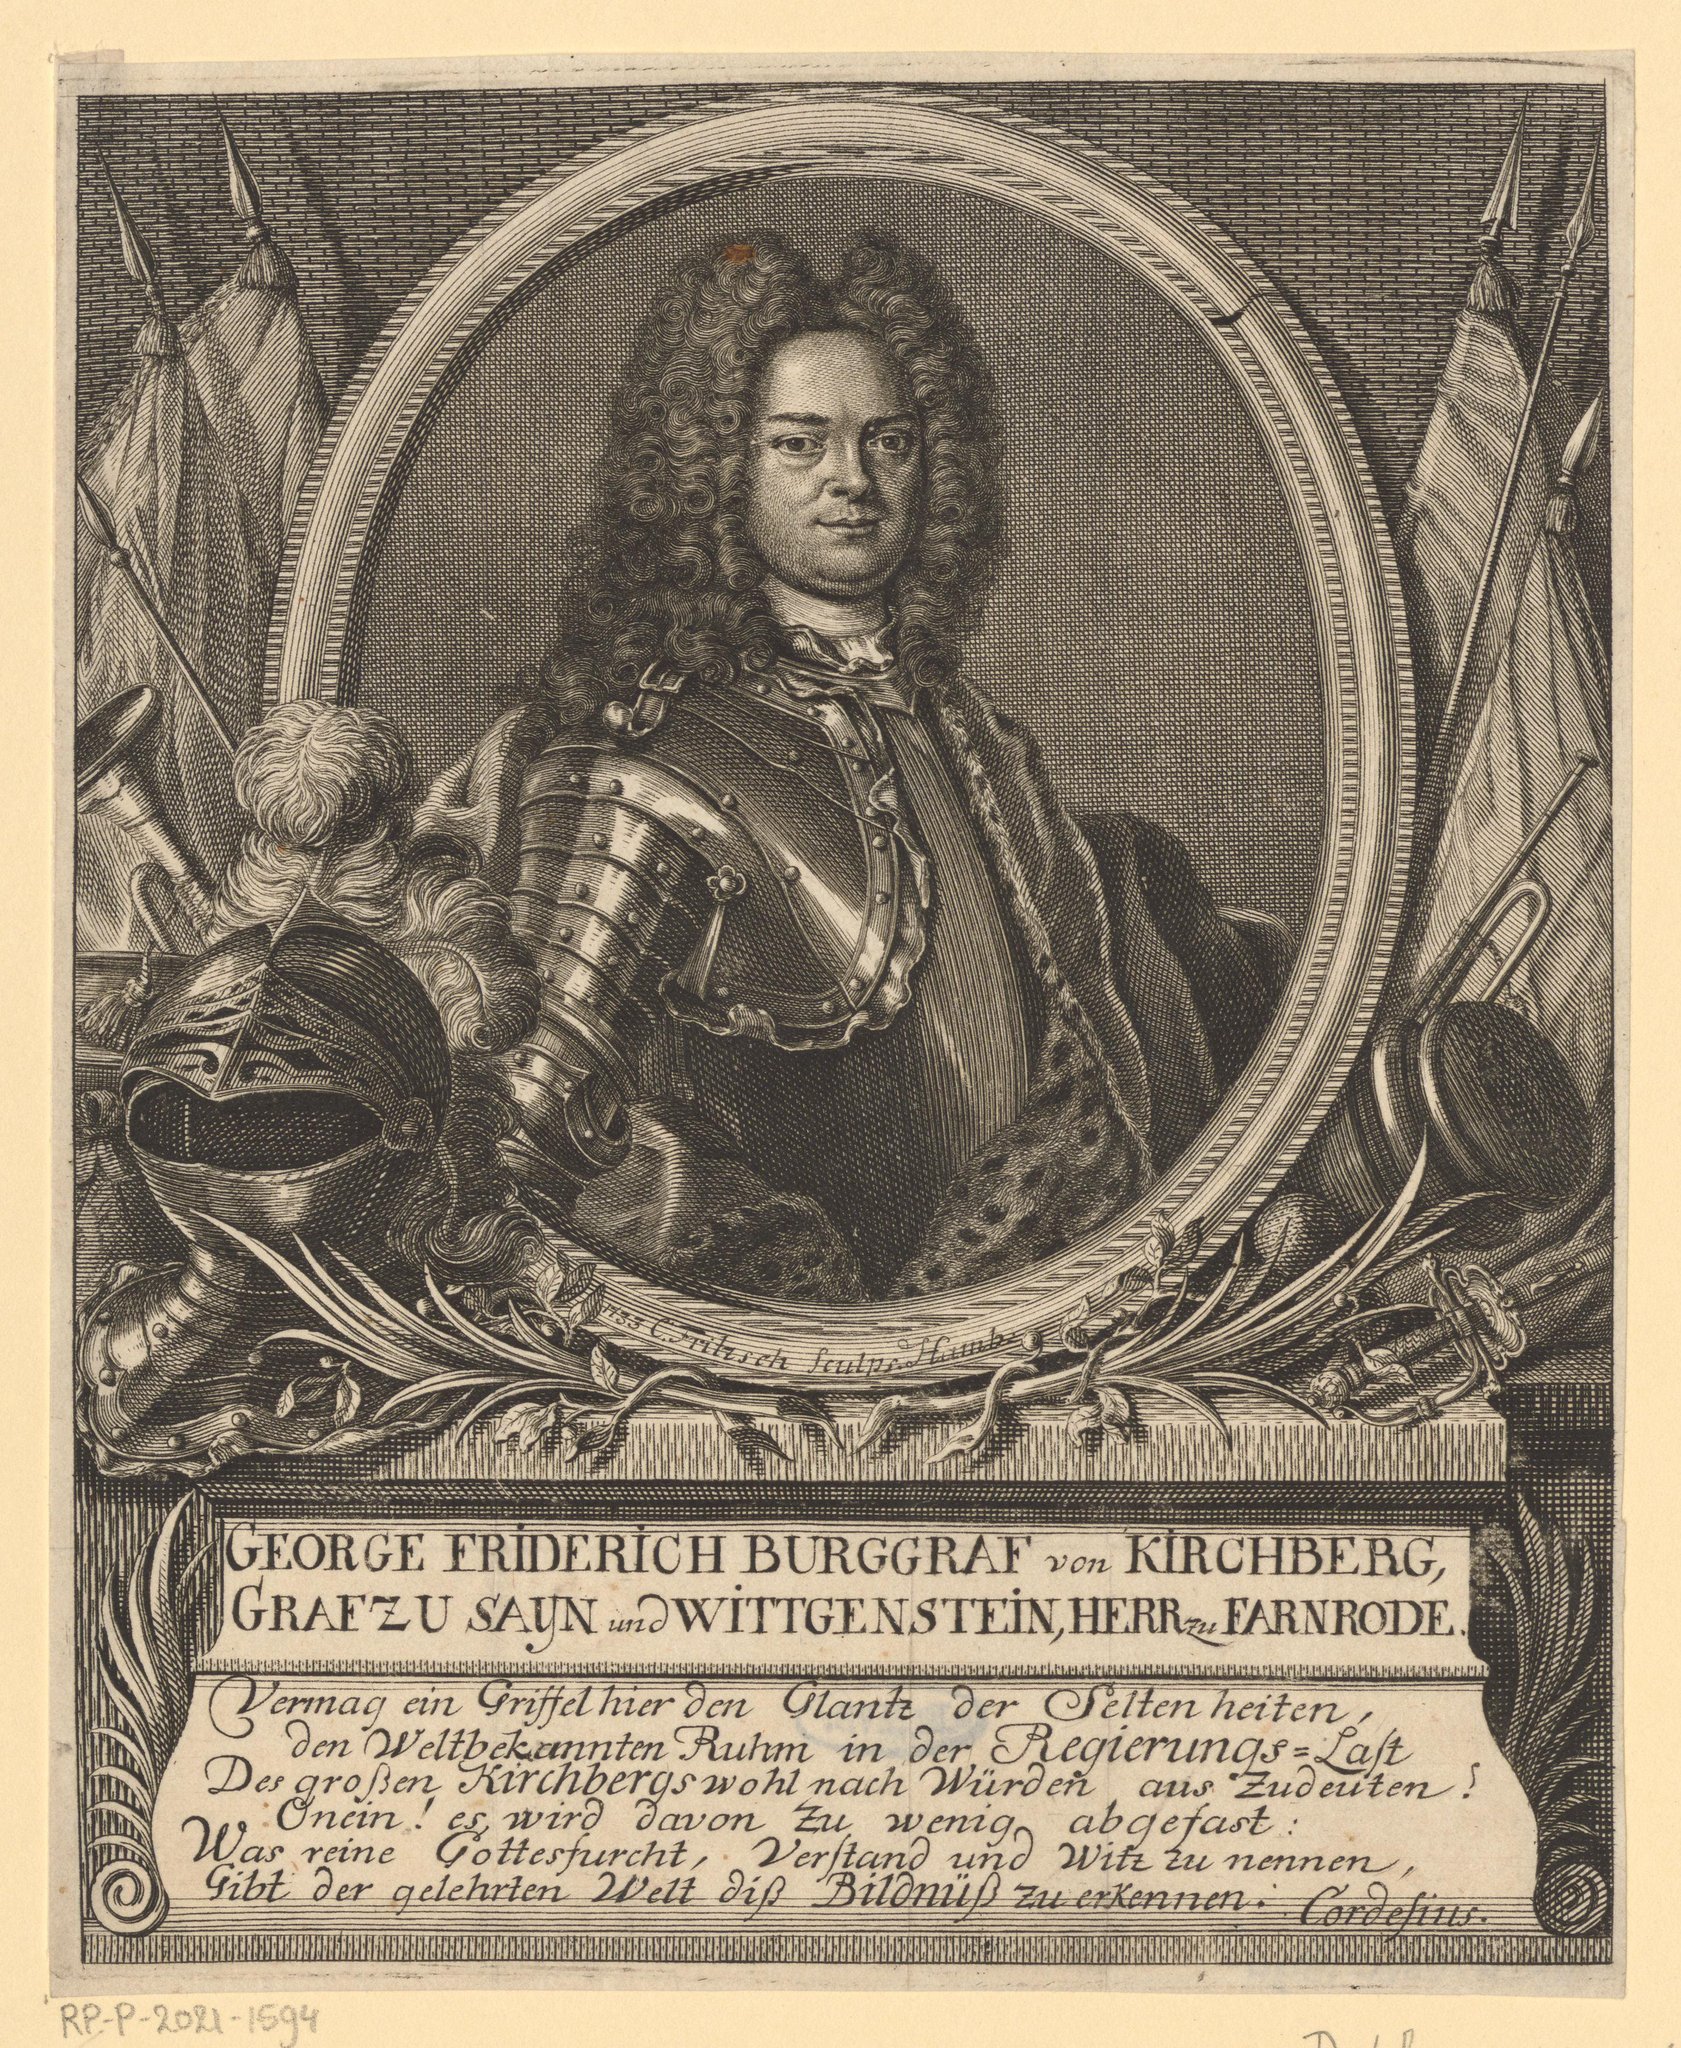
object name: print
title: Portret van Georg Friedrich von Kirchberg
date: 1733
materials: paper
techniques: engraving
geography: hamburg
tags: helmet, armour, historical persons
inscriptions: collector's mark: Lugt 2228